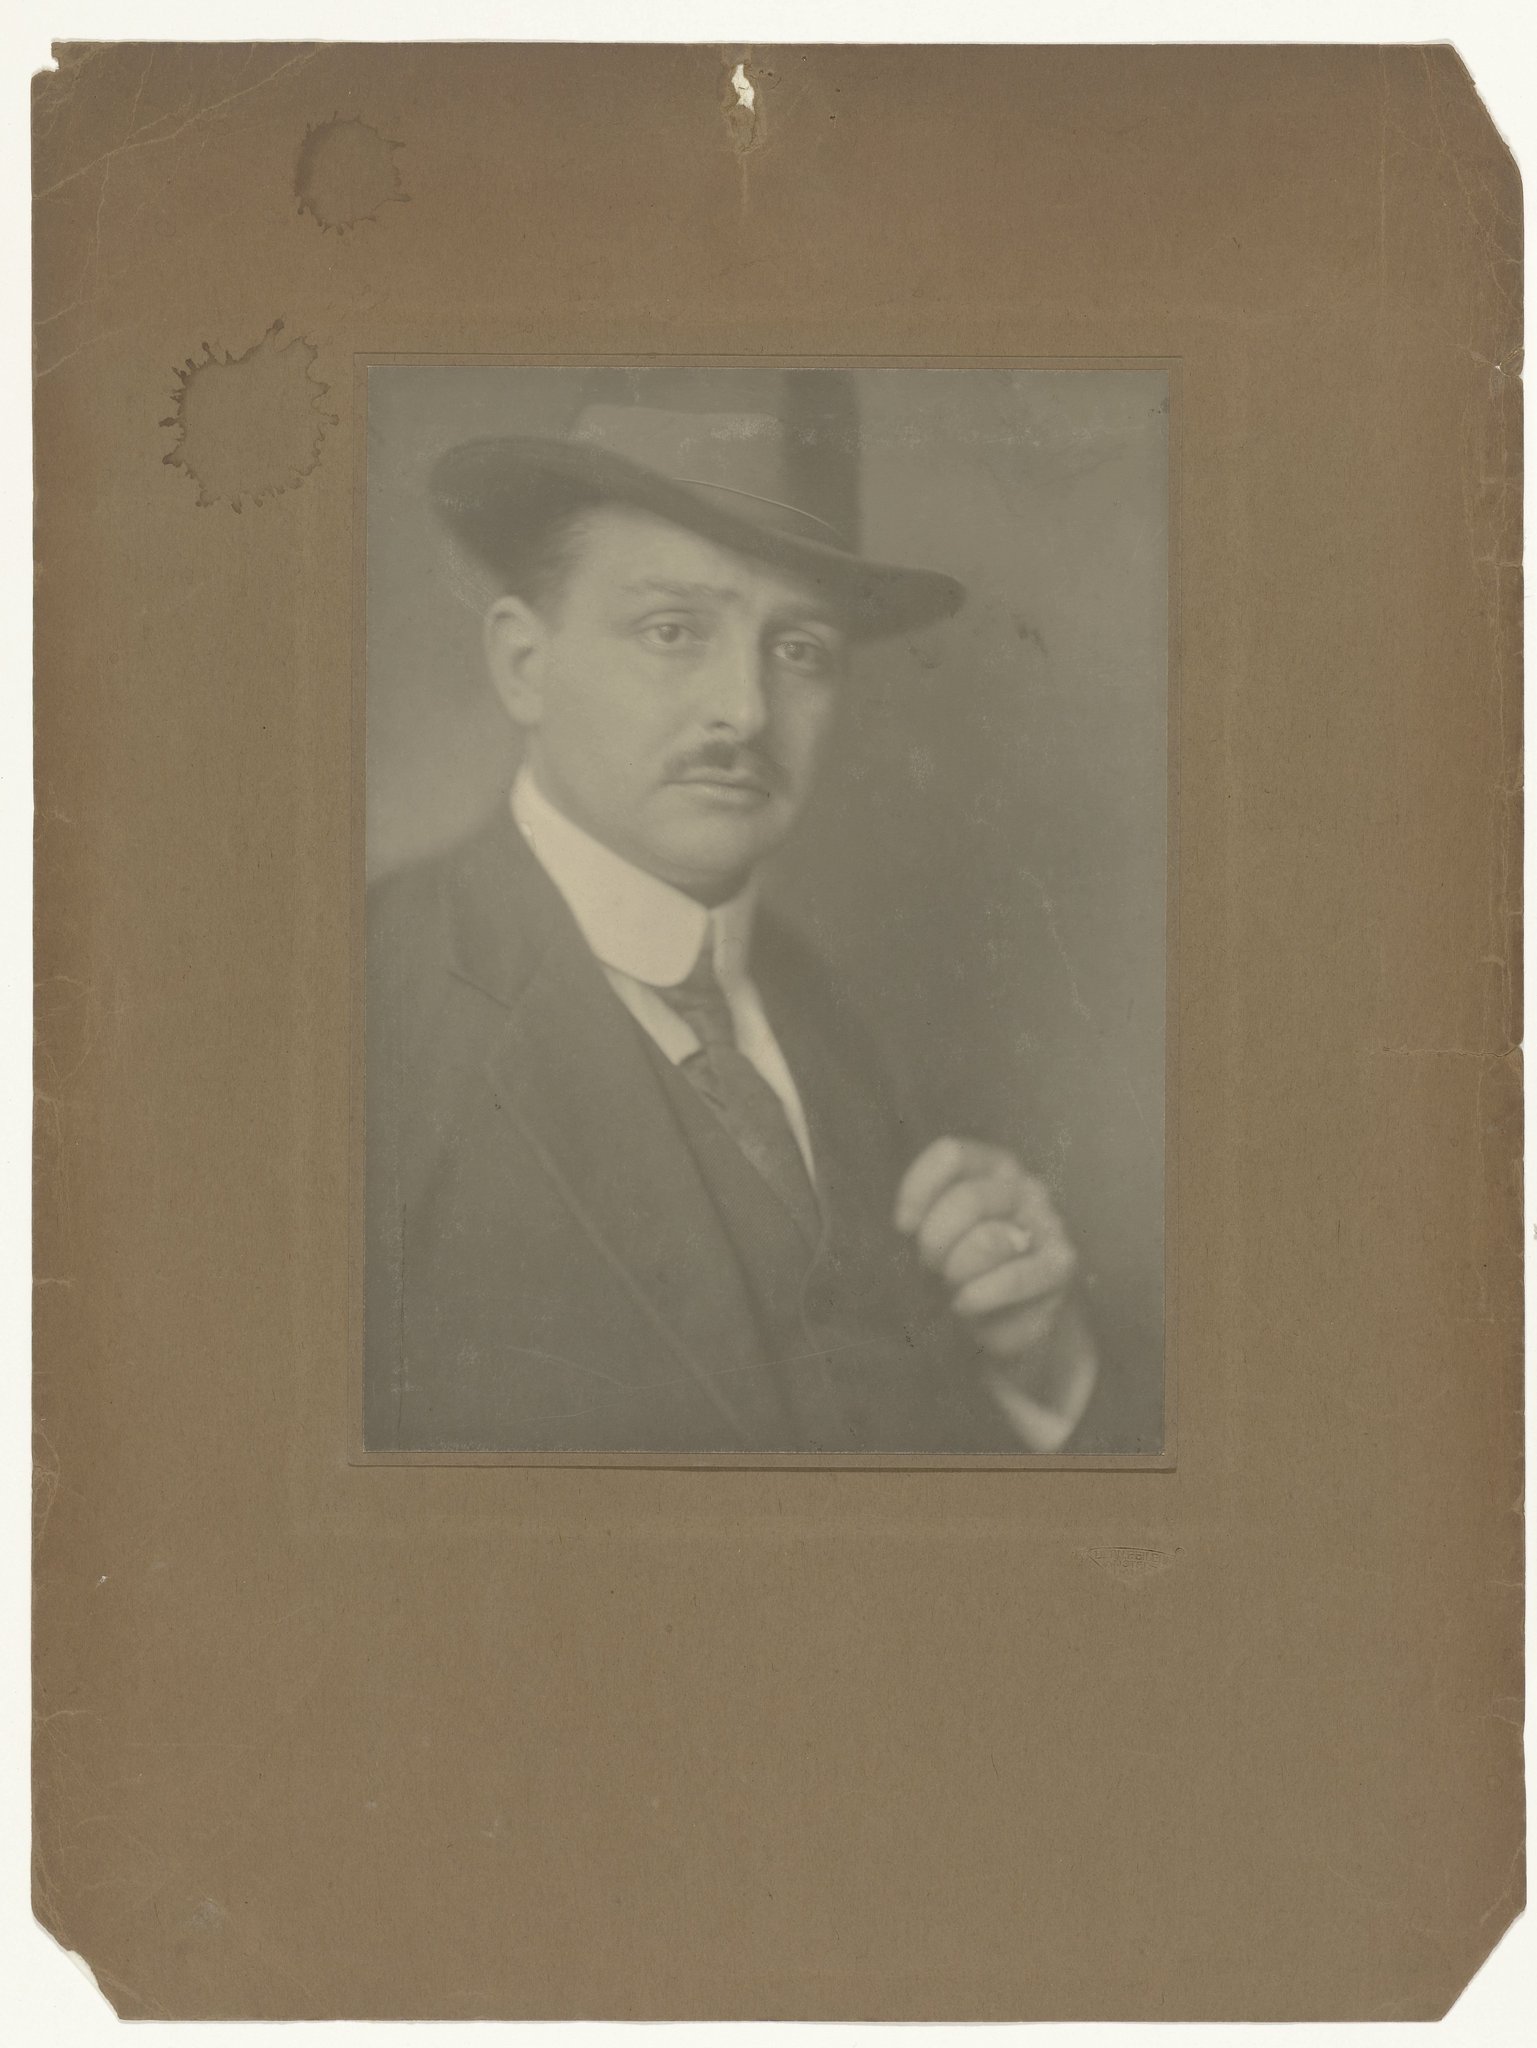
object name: photograph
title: Portret van de fotograaf Jacob Merkelbach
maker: bernard eilers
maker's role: fotograaf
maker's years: 1878-1951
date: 1910-1930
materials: paper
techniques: collodion silver print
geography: amsterdam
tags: amsterdam, jacob merkelbach, portrait, self-portrait of photographer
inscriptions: name: ‘Bern. F.Eilers Amsterdam’